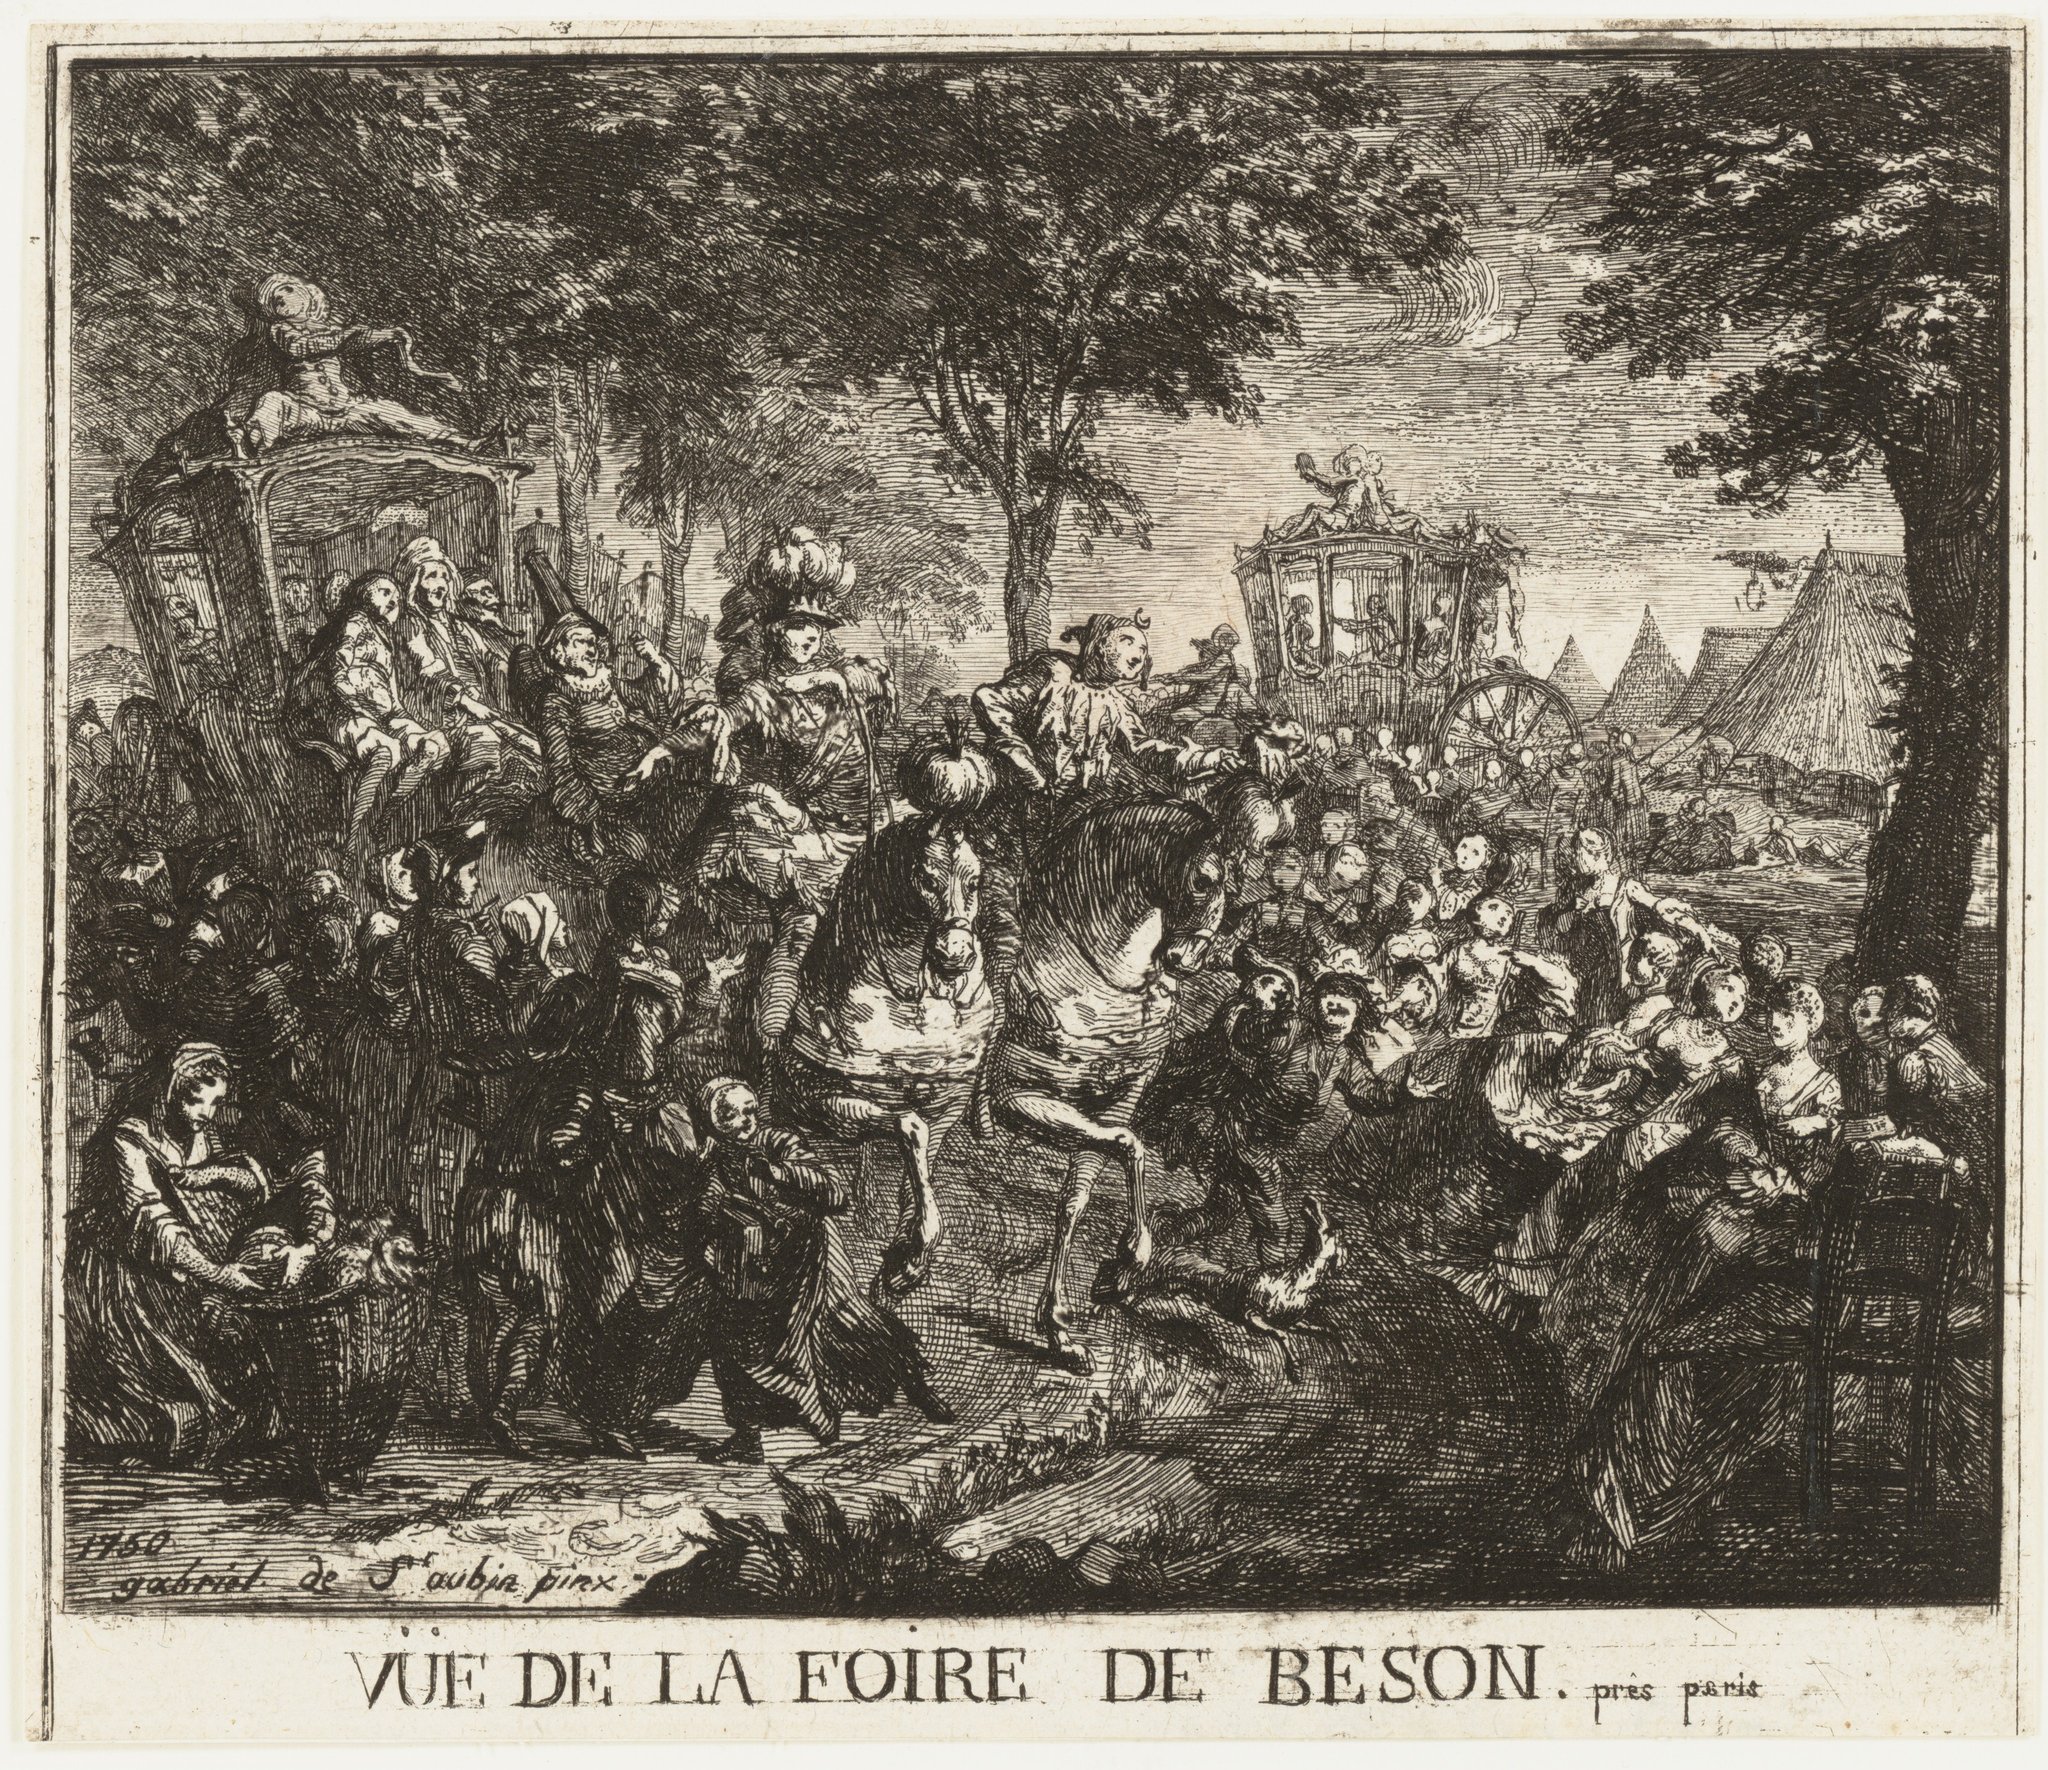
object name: print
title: The Fair at Bezons (Vue de la Foire de Bezons)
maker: gabriel de saint-aubin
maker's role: artist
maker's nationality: french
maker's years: 1724-1780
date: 1750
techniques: etching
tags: horses,crowd,carriages